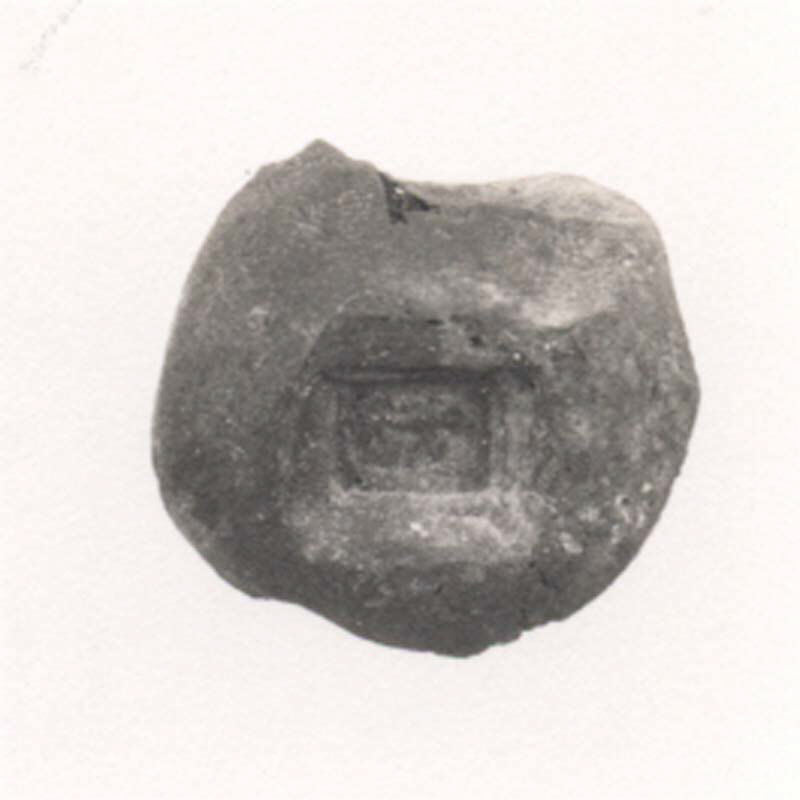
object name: sealing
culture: sasanian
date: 601-700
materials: clay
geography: iran